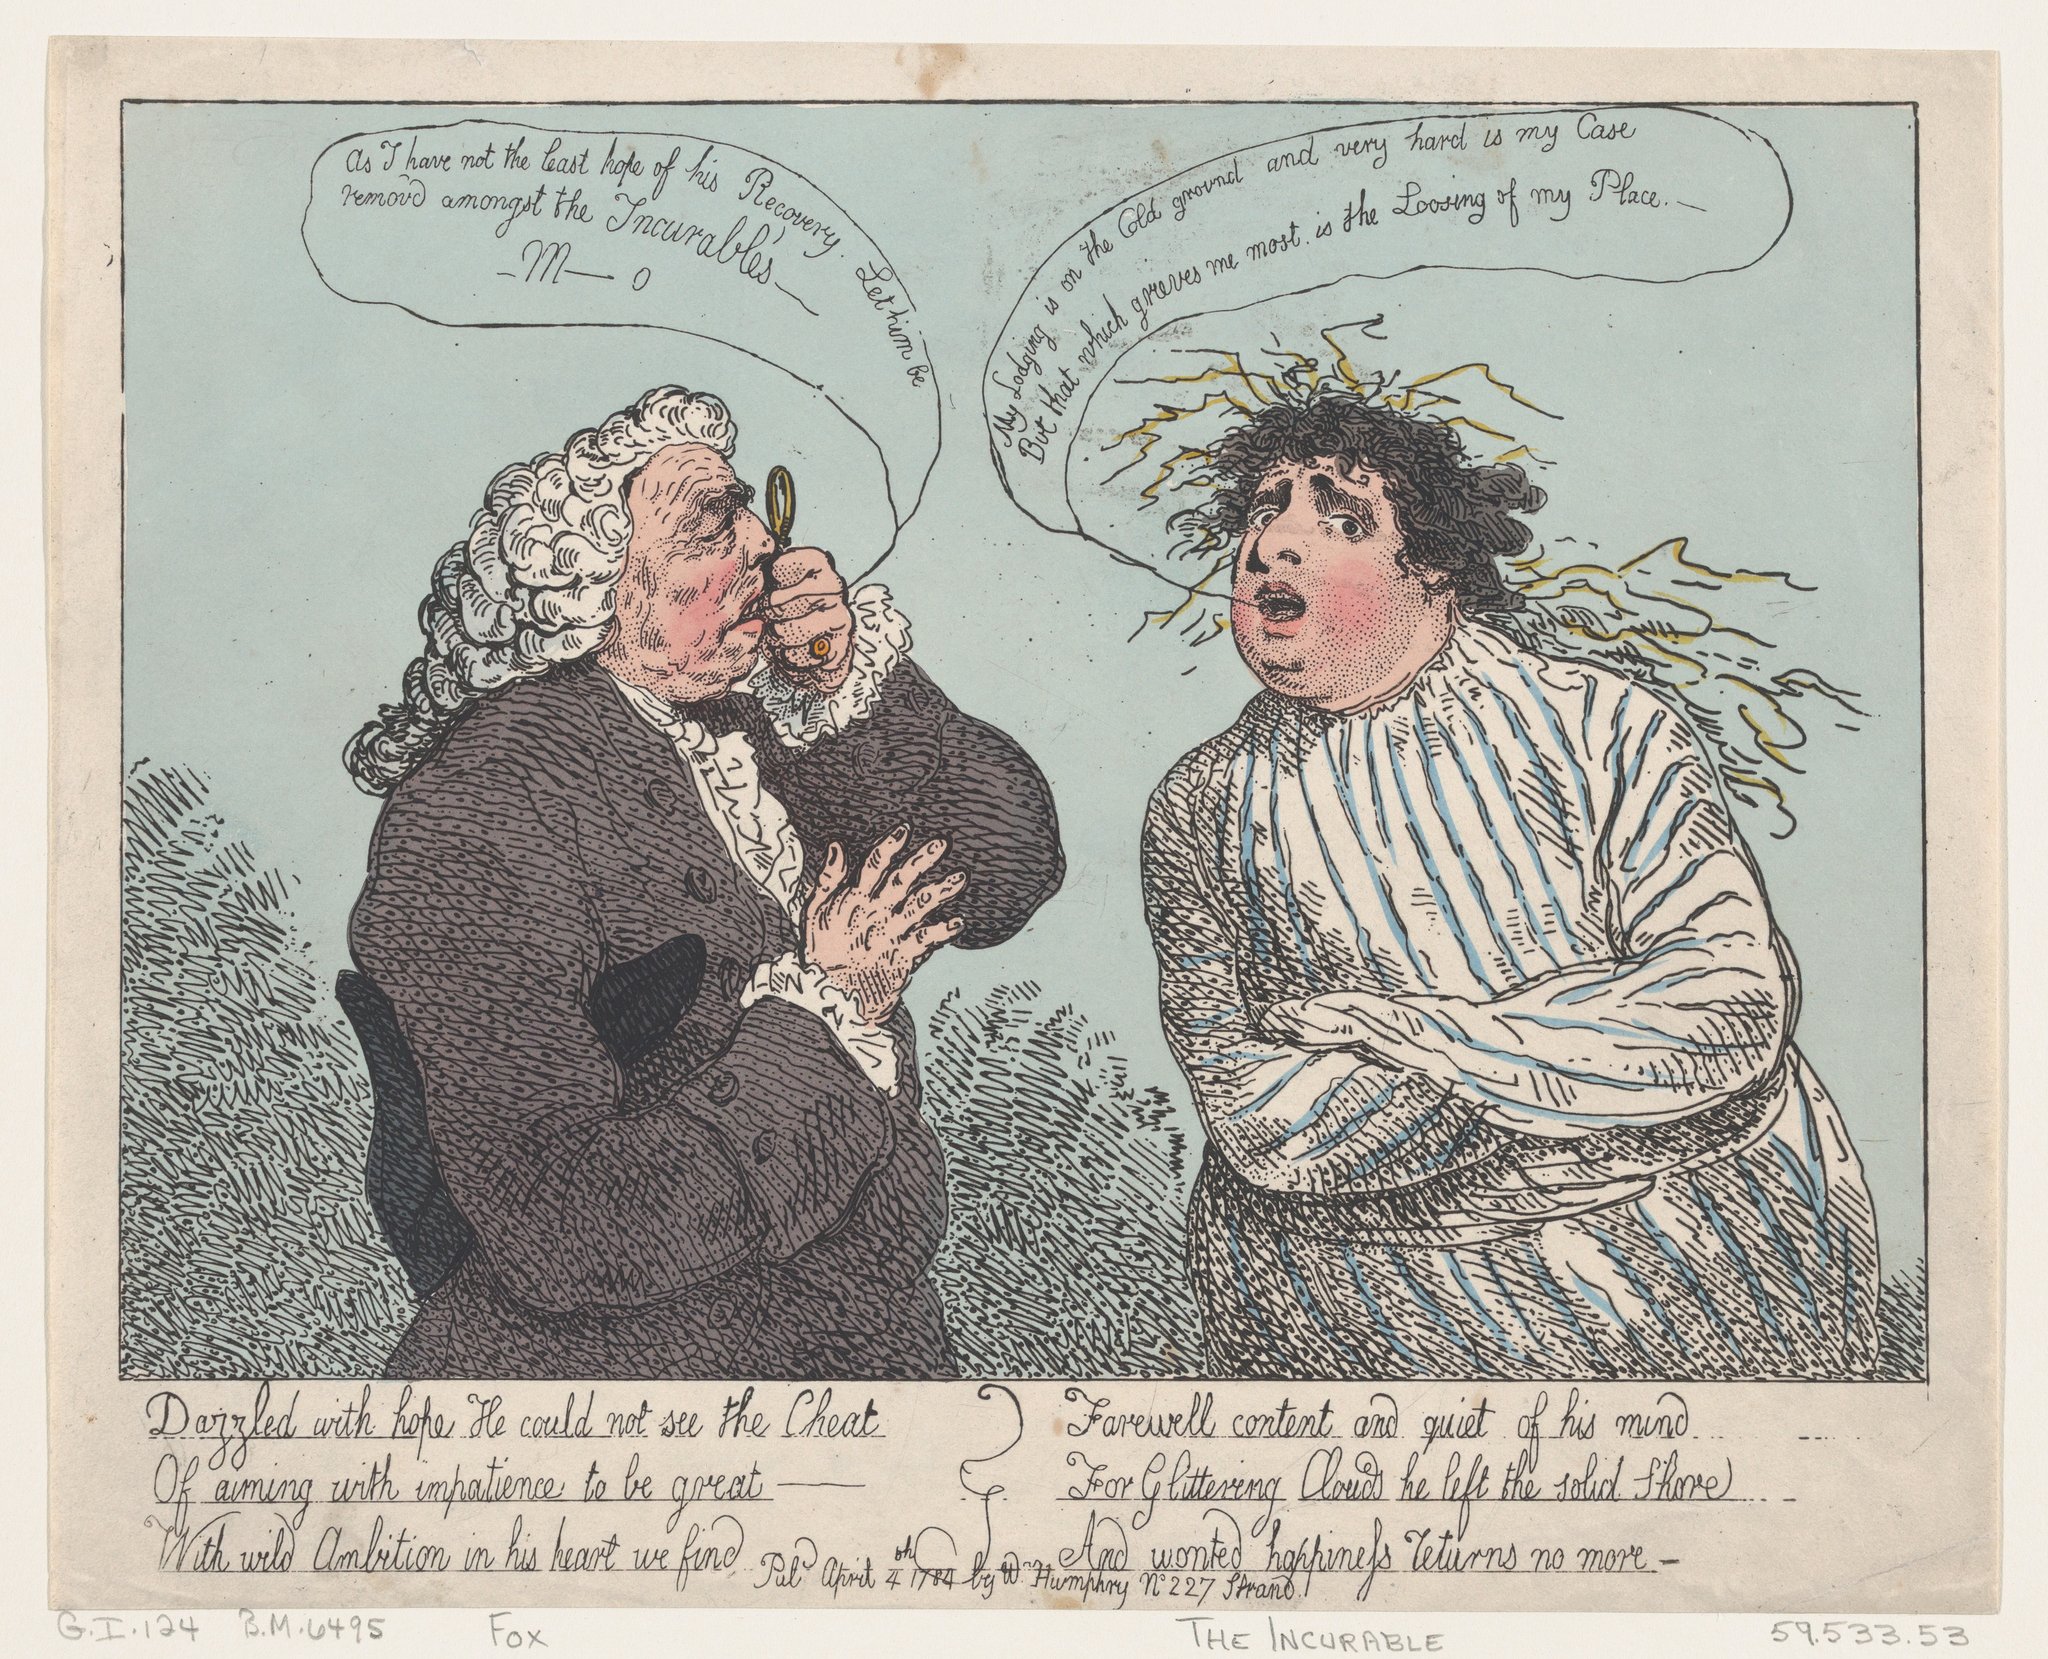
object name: print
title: The Incurable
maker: thomas rowlandson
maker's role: artist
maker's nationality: british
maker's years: 1757-1827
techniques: etching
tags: satire,men,politics